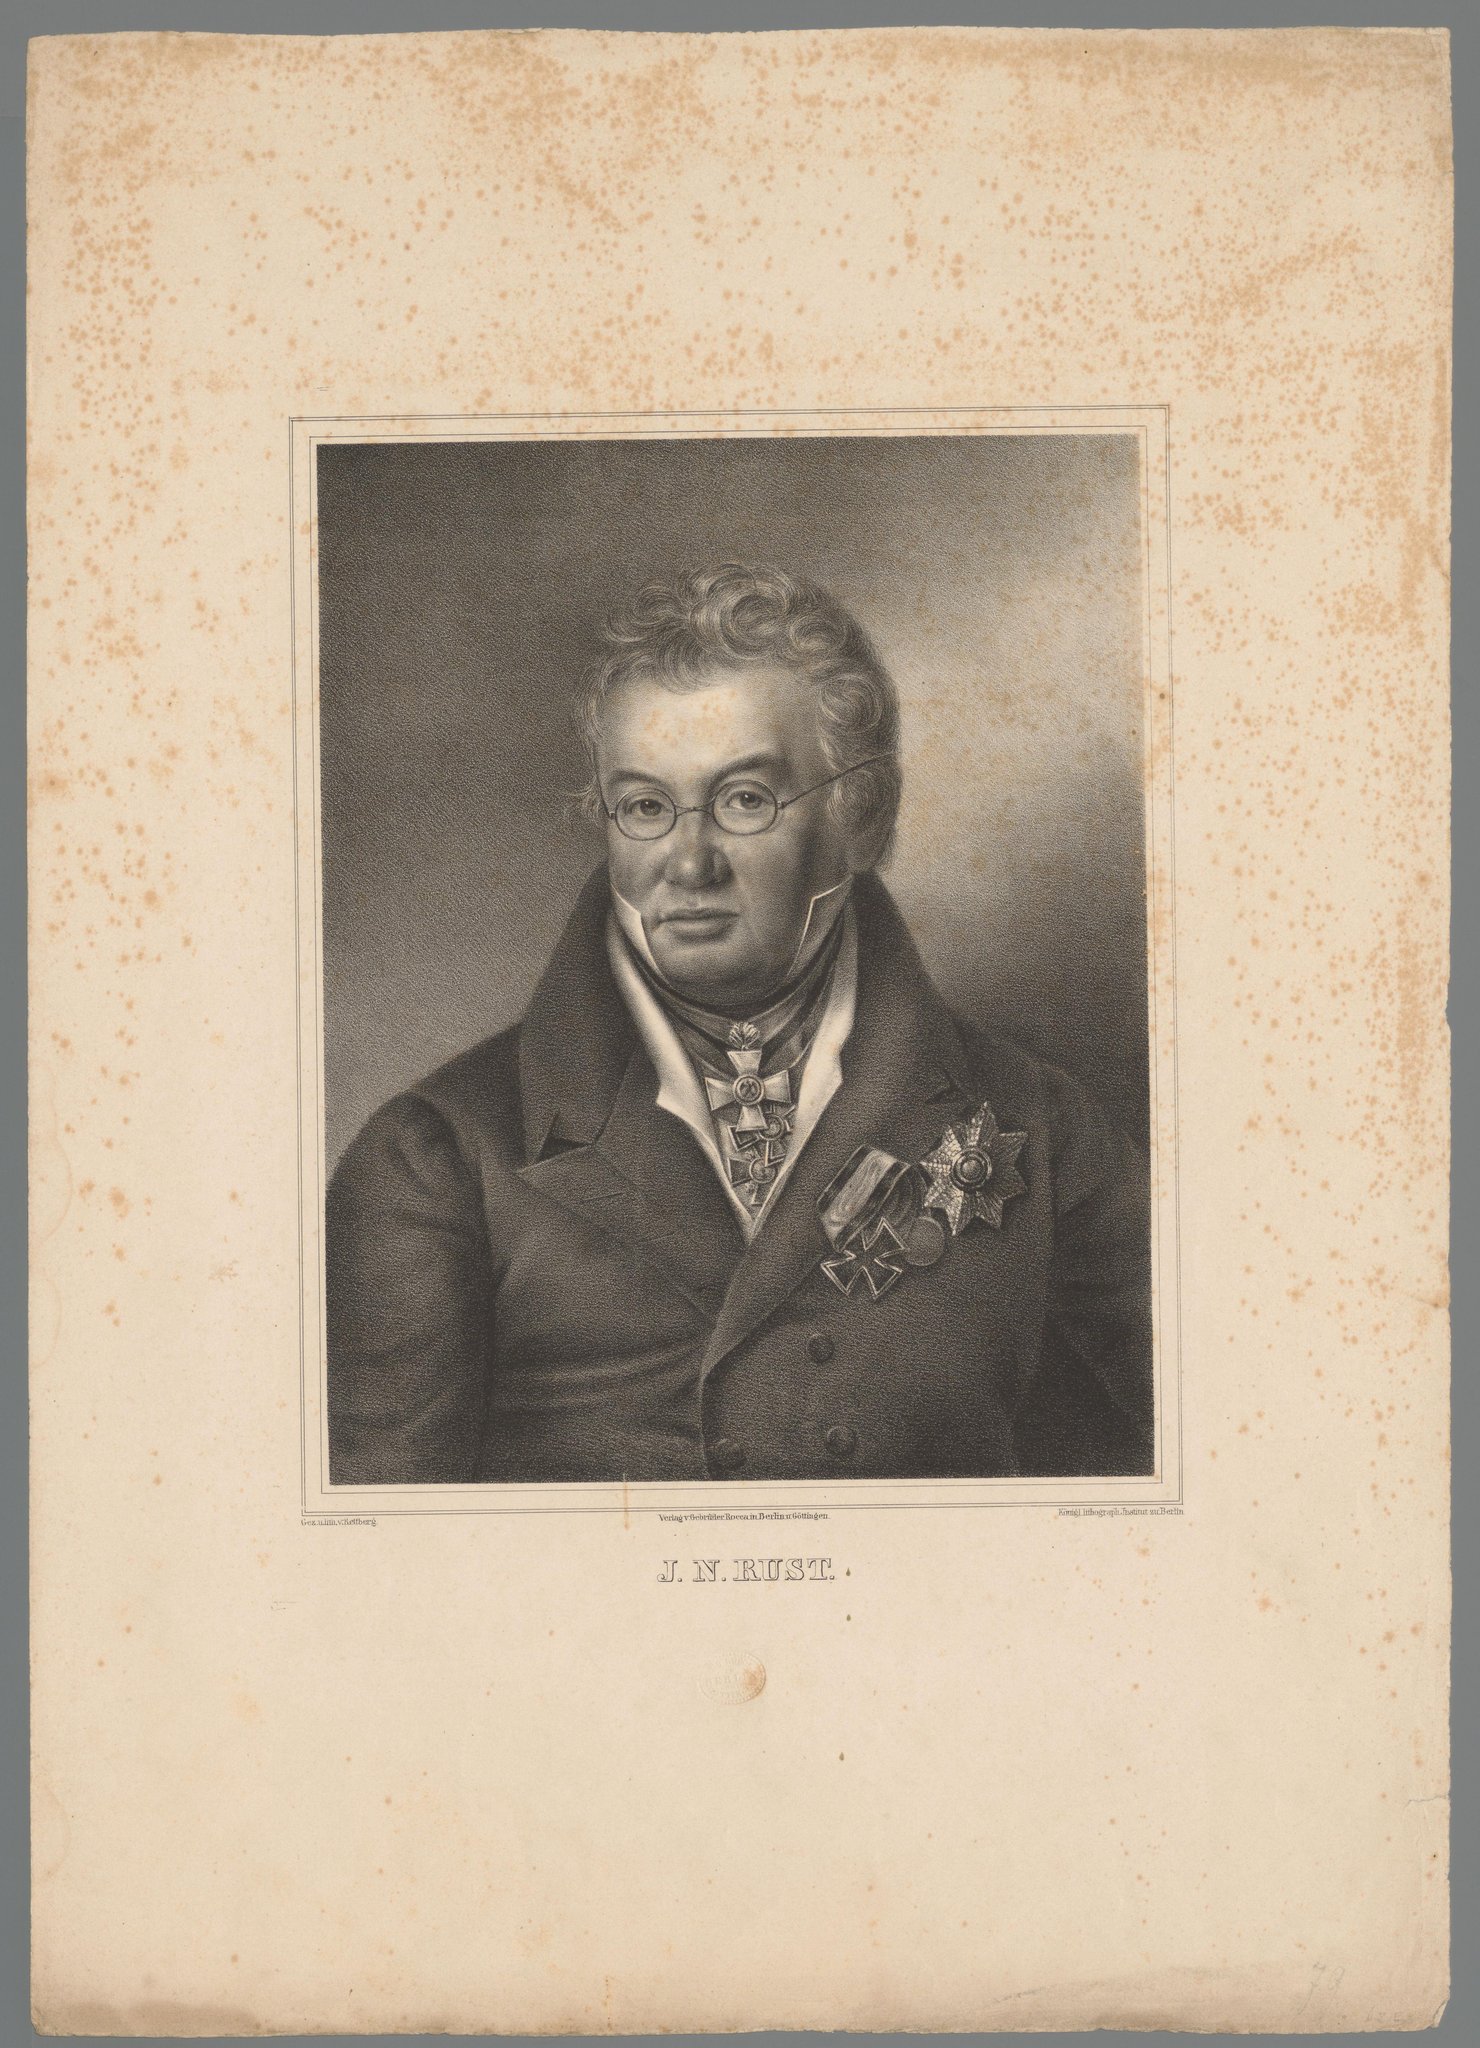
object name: print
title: Portret van Johann Nepomuk Rust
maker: ralf leopold von retberg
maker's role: print maker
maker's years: 1812-1885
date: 1822-1885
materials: paper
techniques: lithograph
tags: johann nepomuk rust, historical persons, barber; surgeon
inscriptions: collector's mark: Lugt 2228, check stamp: Lugt 5514